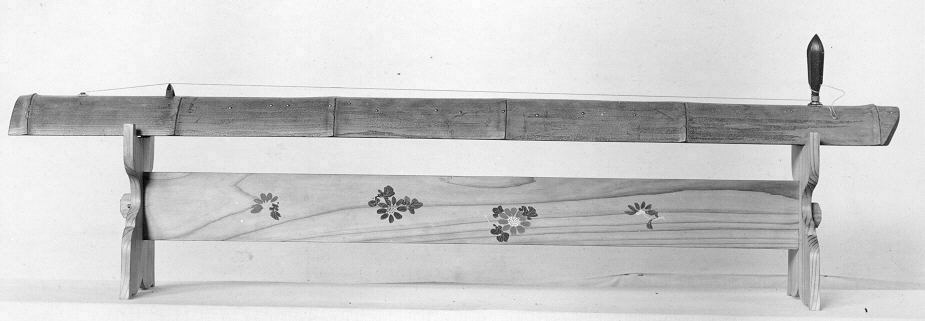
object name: ichigen kin 一絃琴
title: Ichigen-kin (一絃琴)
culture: japanese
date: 1801-1900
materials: bamboo, wood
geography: japan